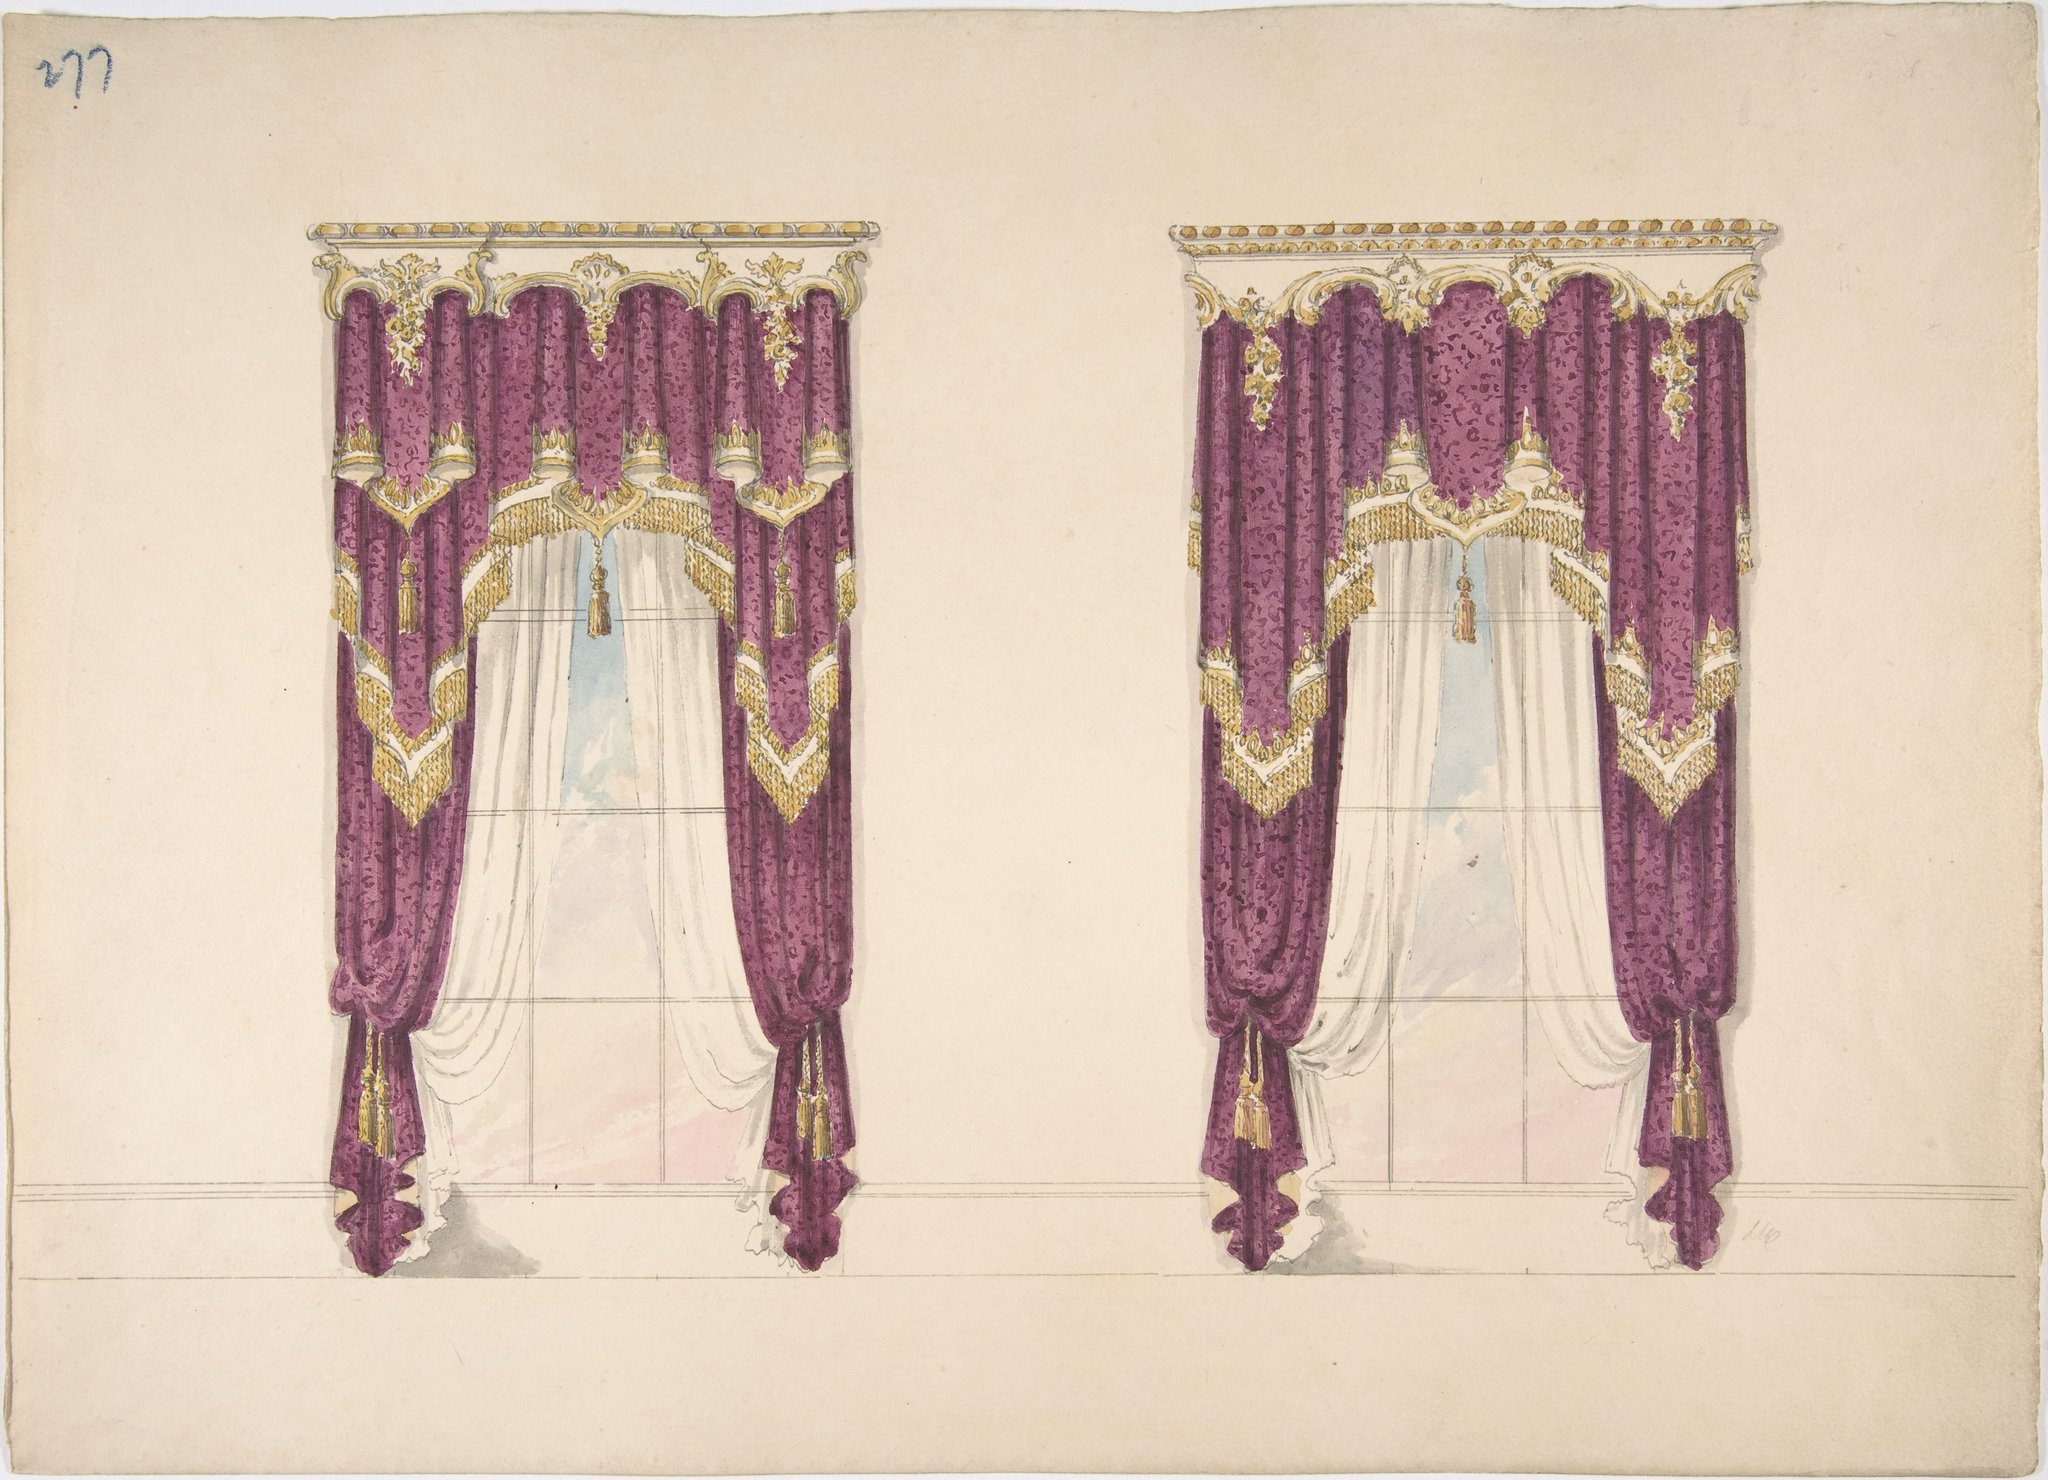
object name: drawing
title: Design for Purple Curtains with Gold Fringes and a Gold and White Pediment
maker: anonymous, british, 19th century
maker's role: artist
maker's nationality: british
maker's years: 1800-1900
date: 1801-1833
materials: ink, watercolor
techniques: brush, pen, wash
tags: curtains